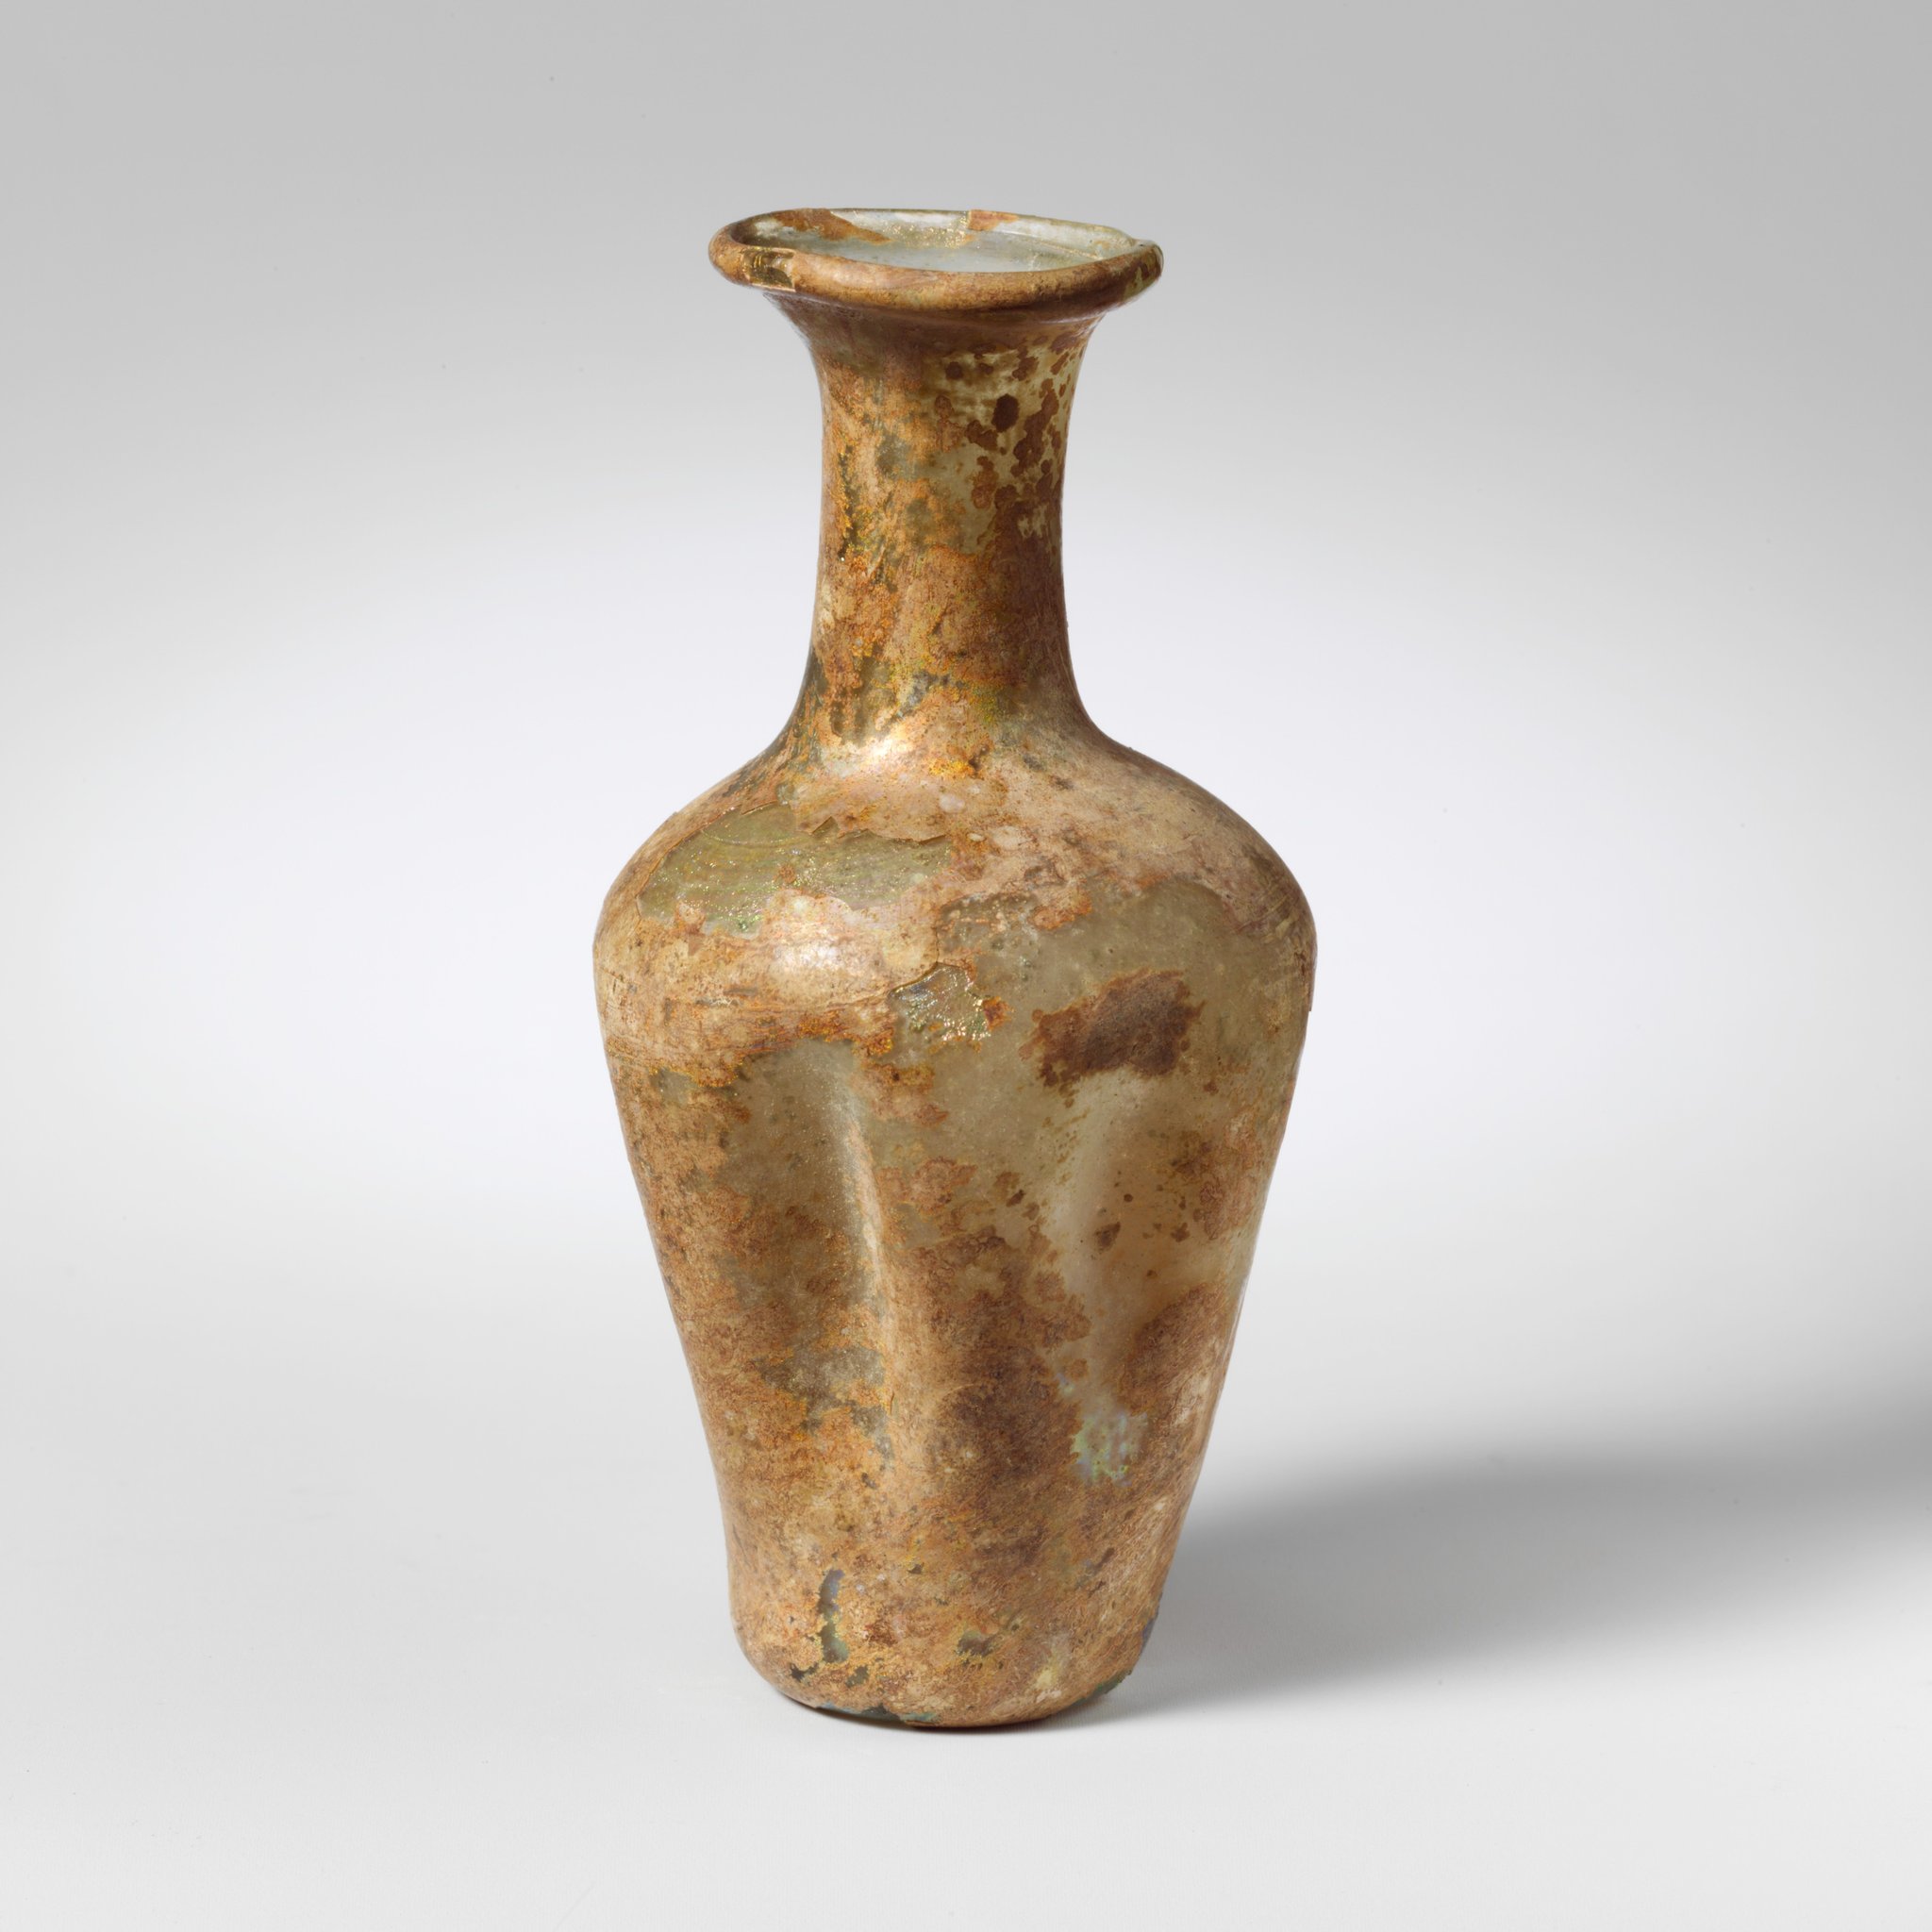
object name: flask, indented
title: Glass indented flask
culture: roman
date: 101-300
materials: glass